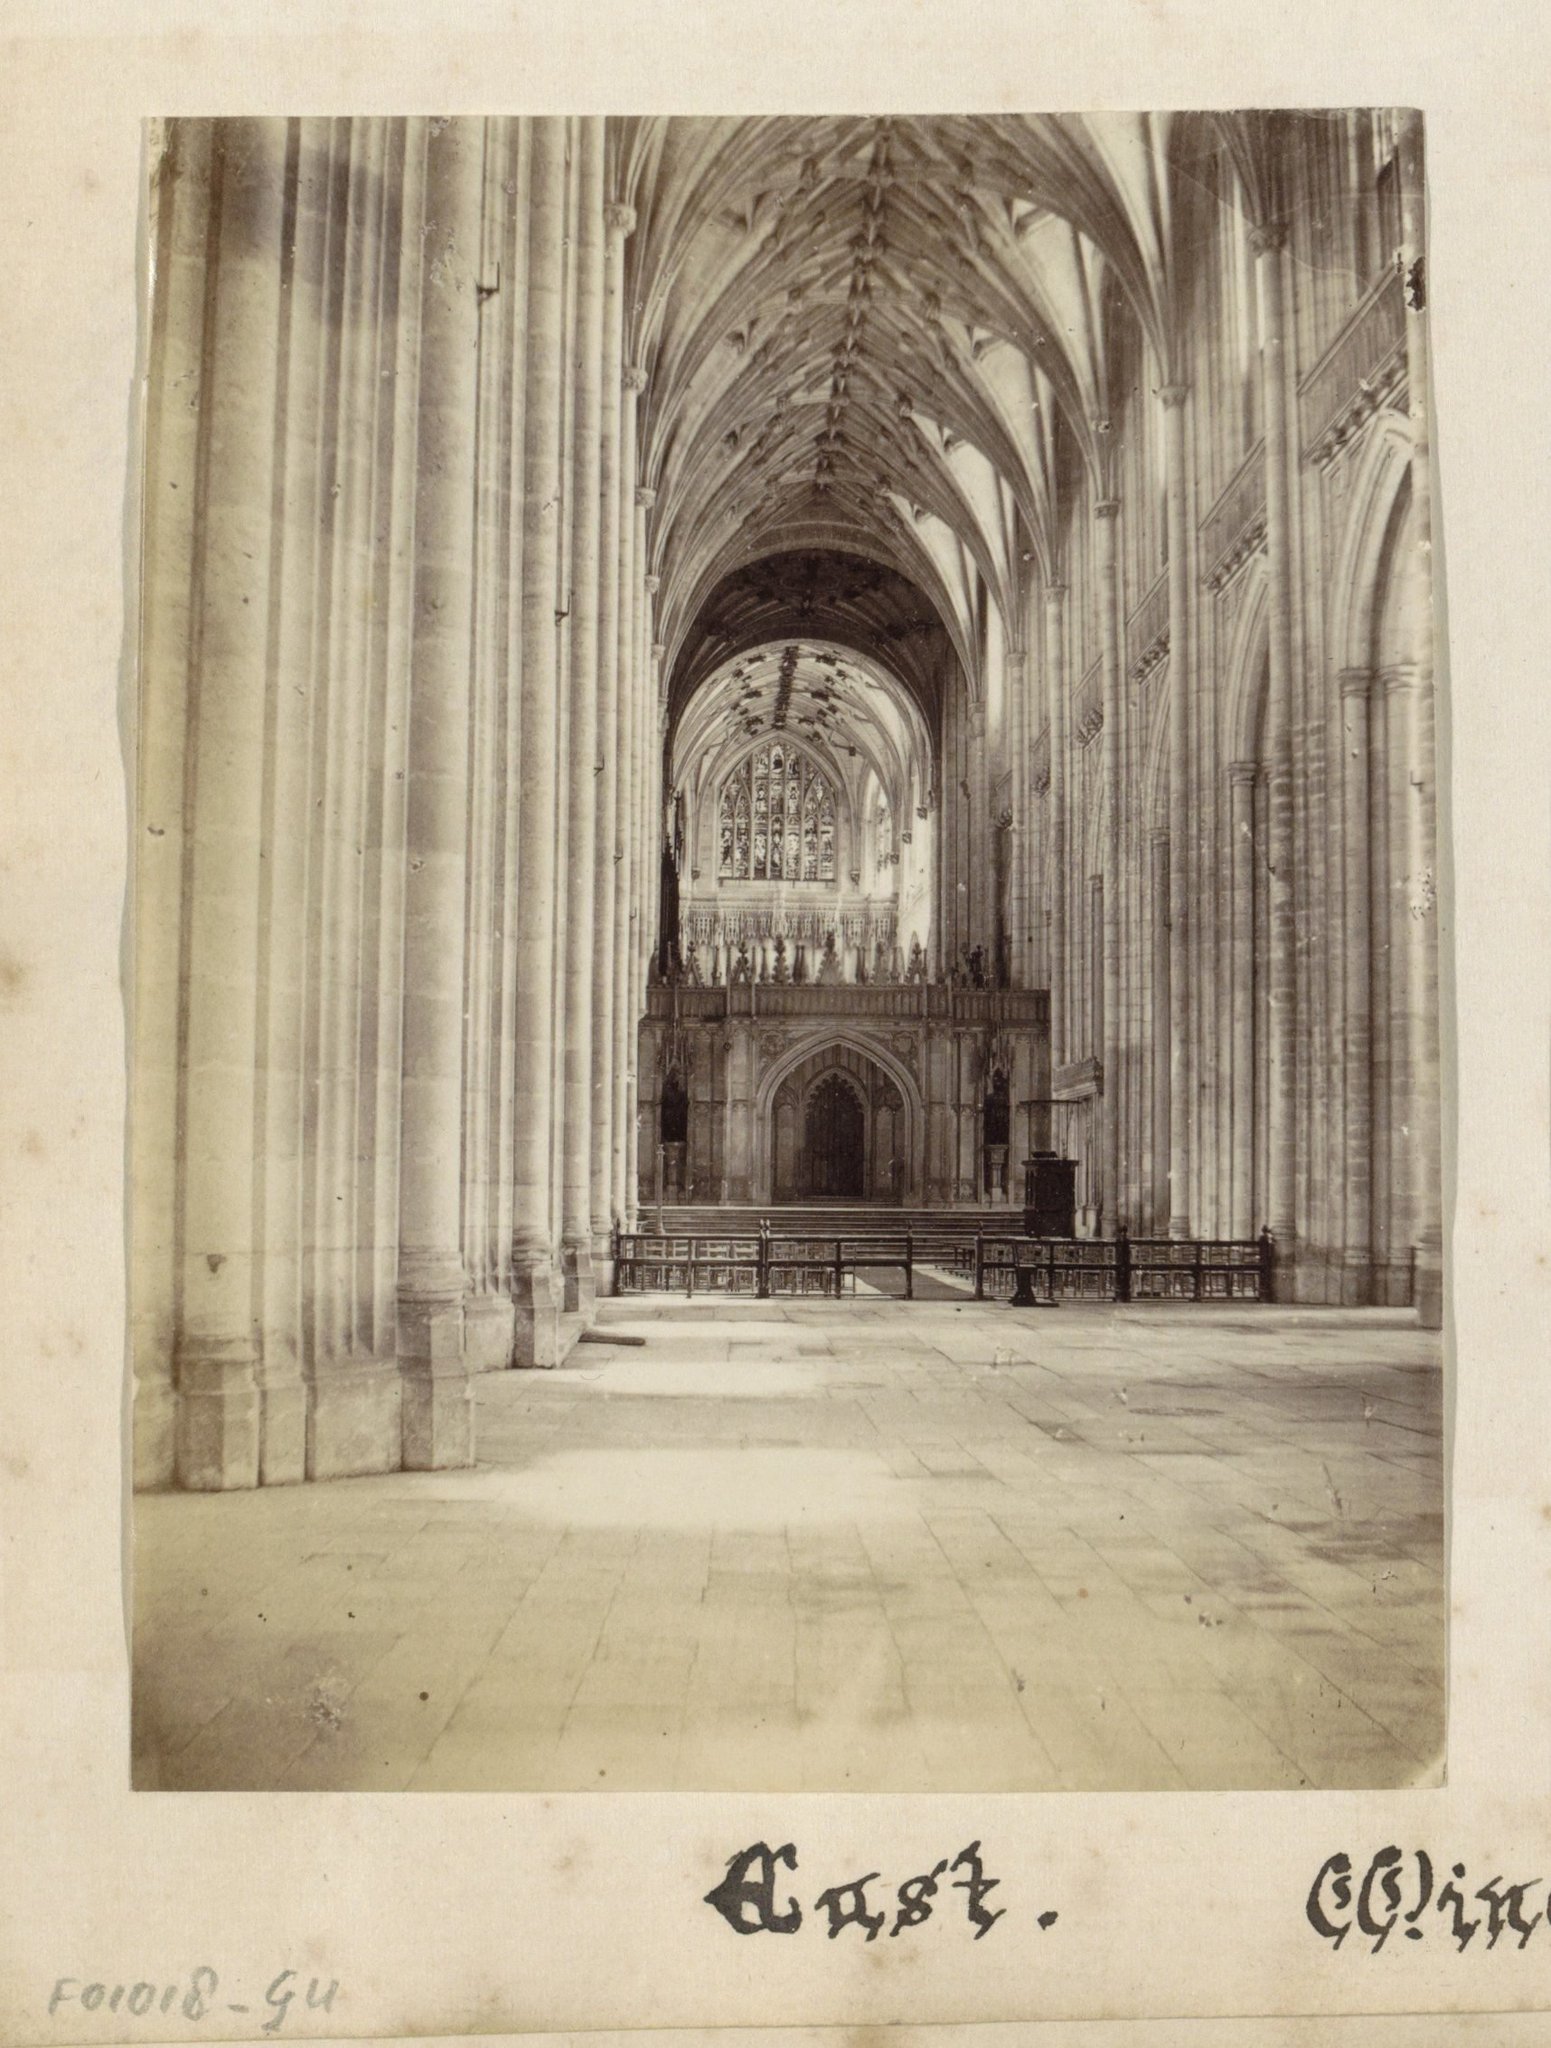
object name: photograph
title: Winchester East.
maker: Anonymous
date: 1860-1870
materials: paper, photographic support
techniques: albumen print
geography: winchester cathedral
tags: church-window, e.g. rose-window, parts of church interior (seats), parts of church interior: nave, parts of church interior: choir, winchester cathedral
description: Onderdeel van Engels familiealbum met foto's van personen, reizen, cricket en kunstwerken.